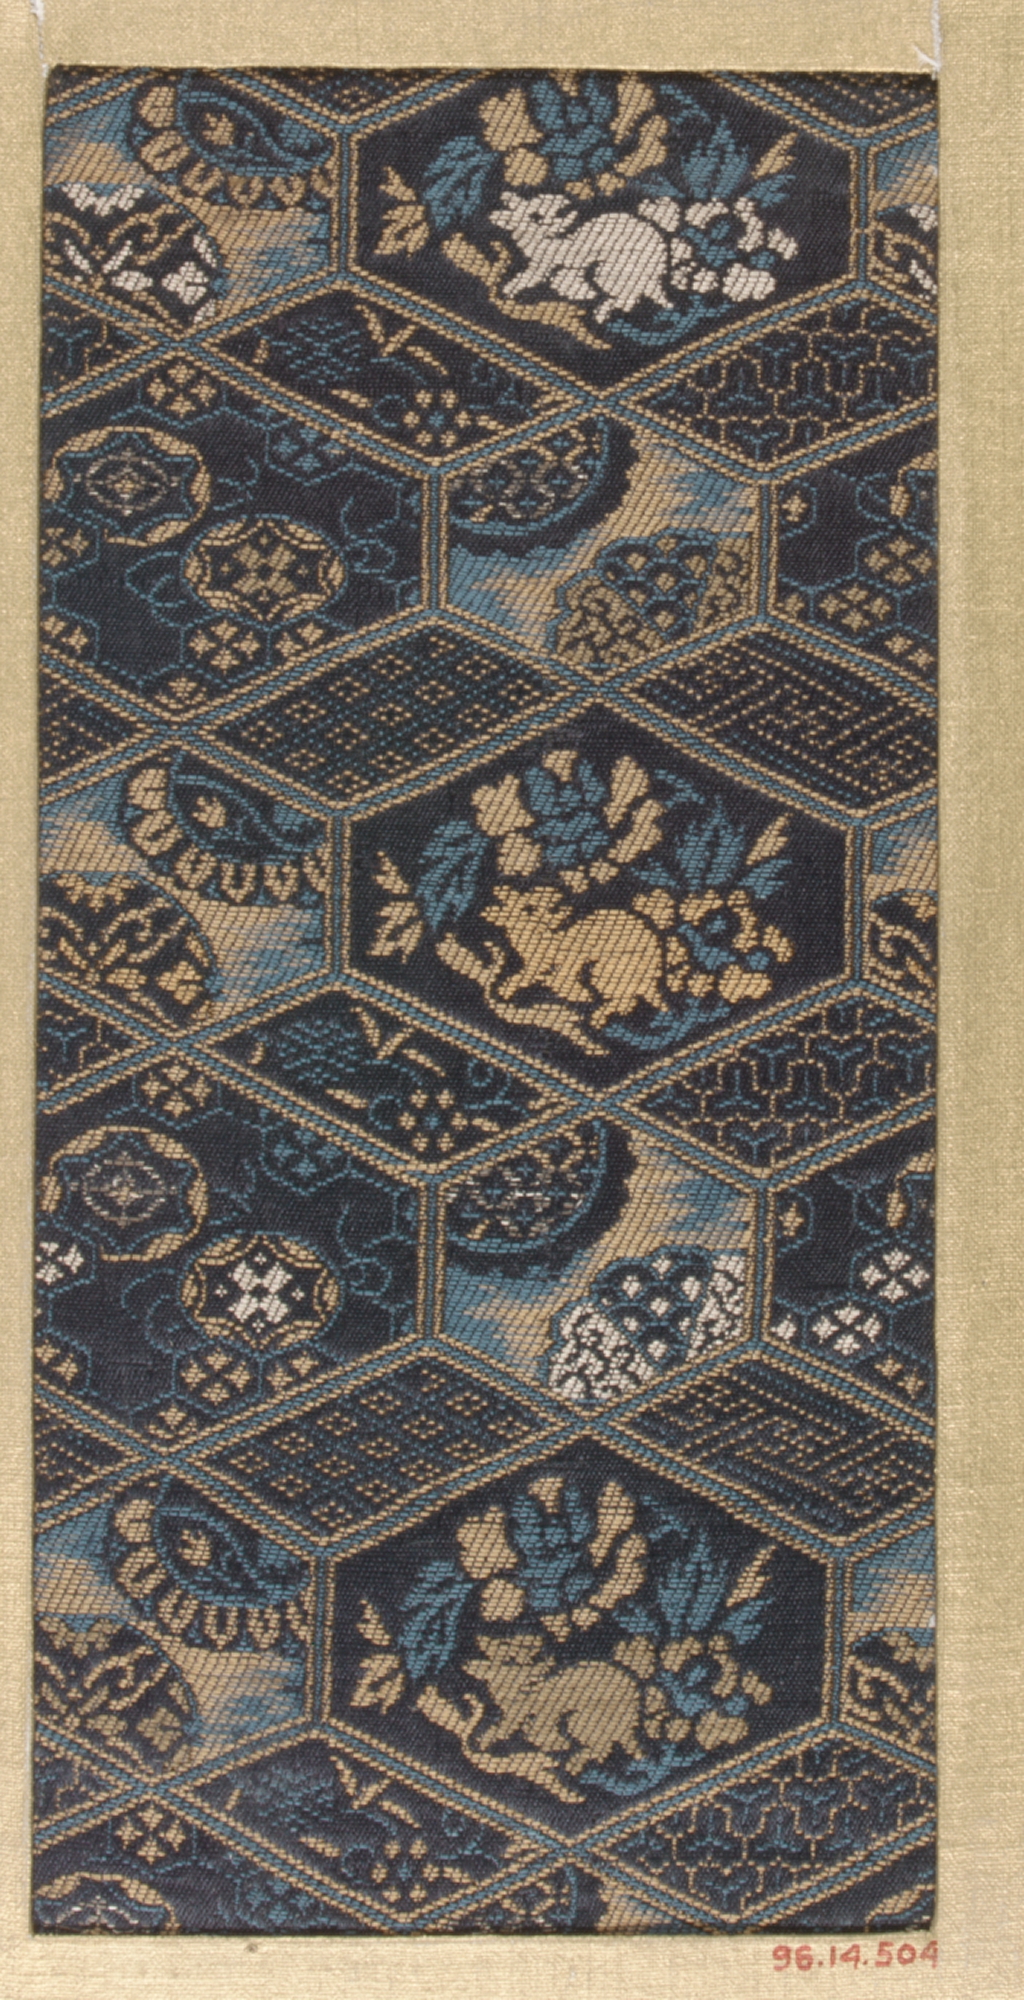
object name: piece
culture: japanese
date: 1701-1900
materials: silk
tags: animals,flowers